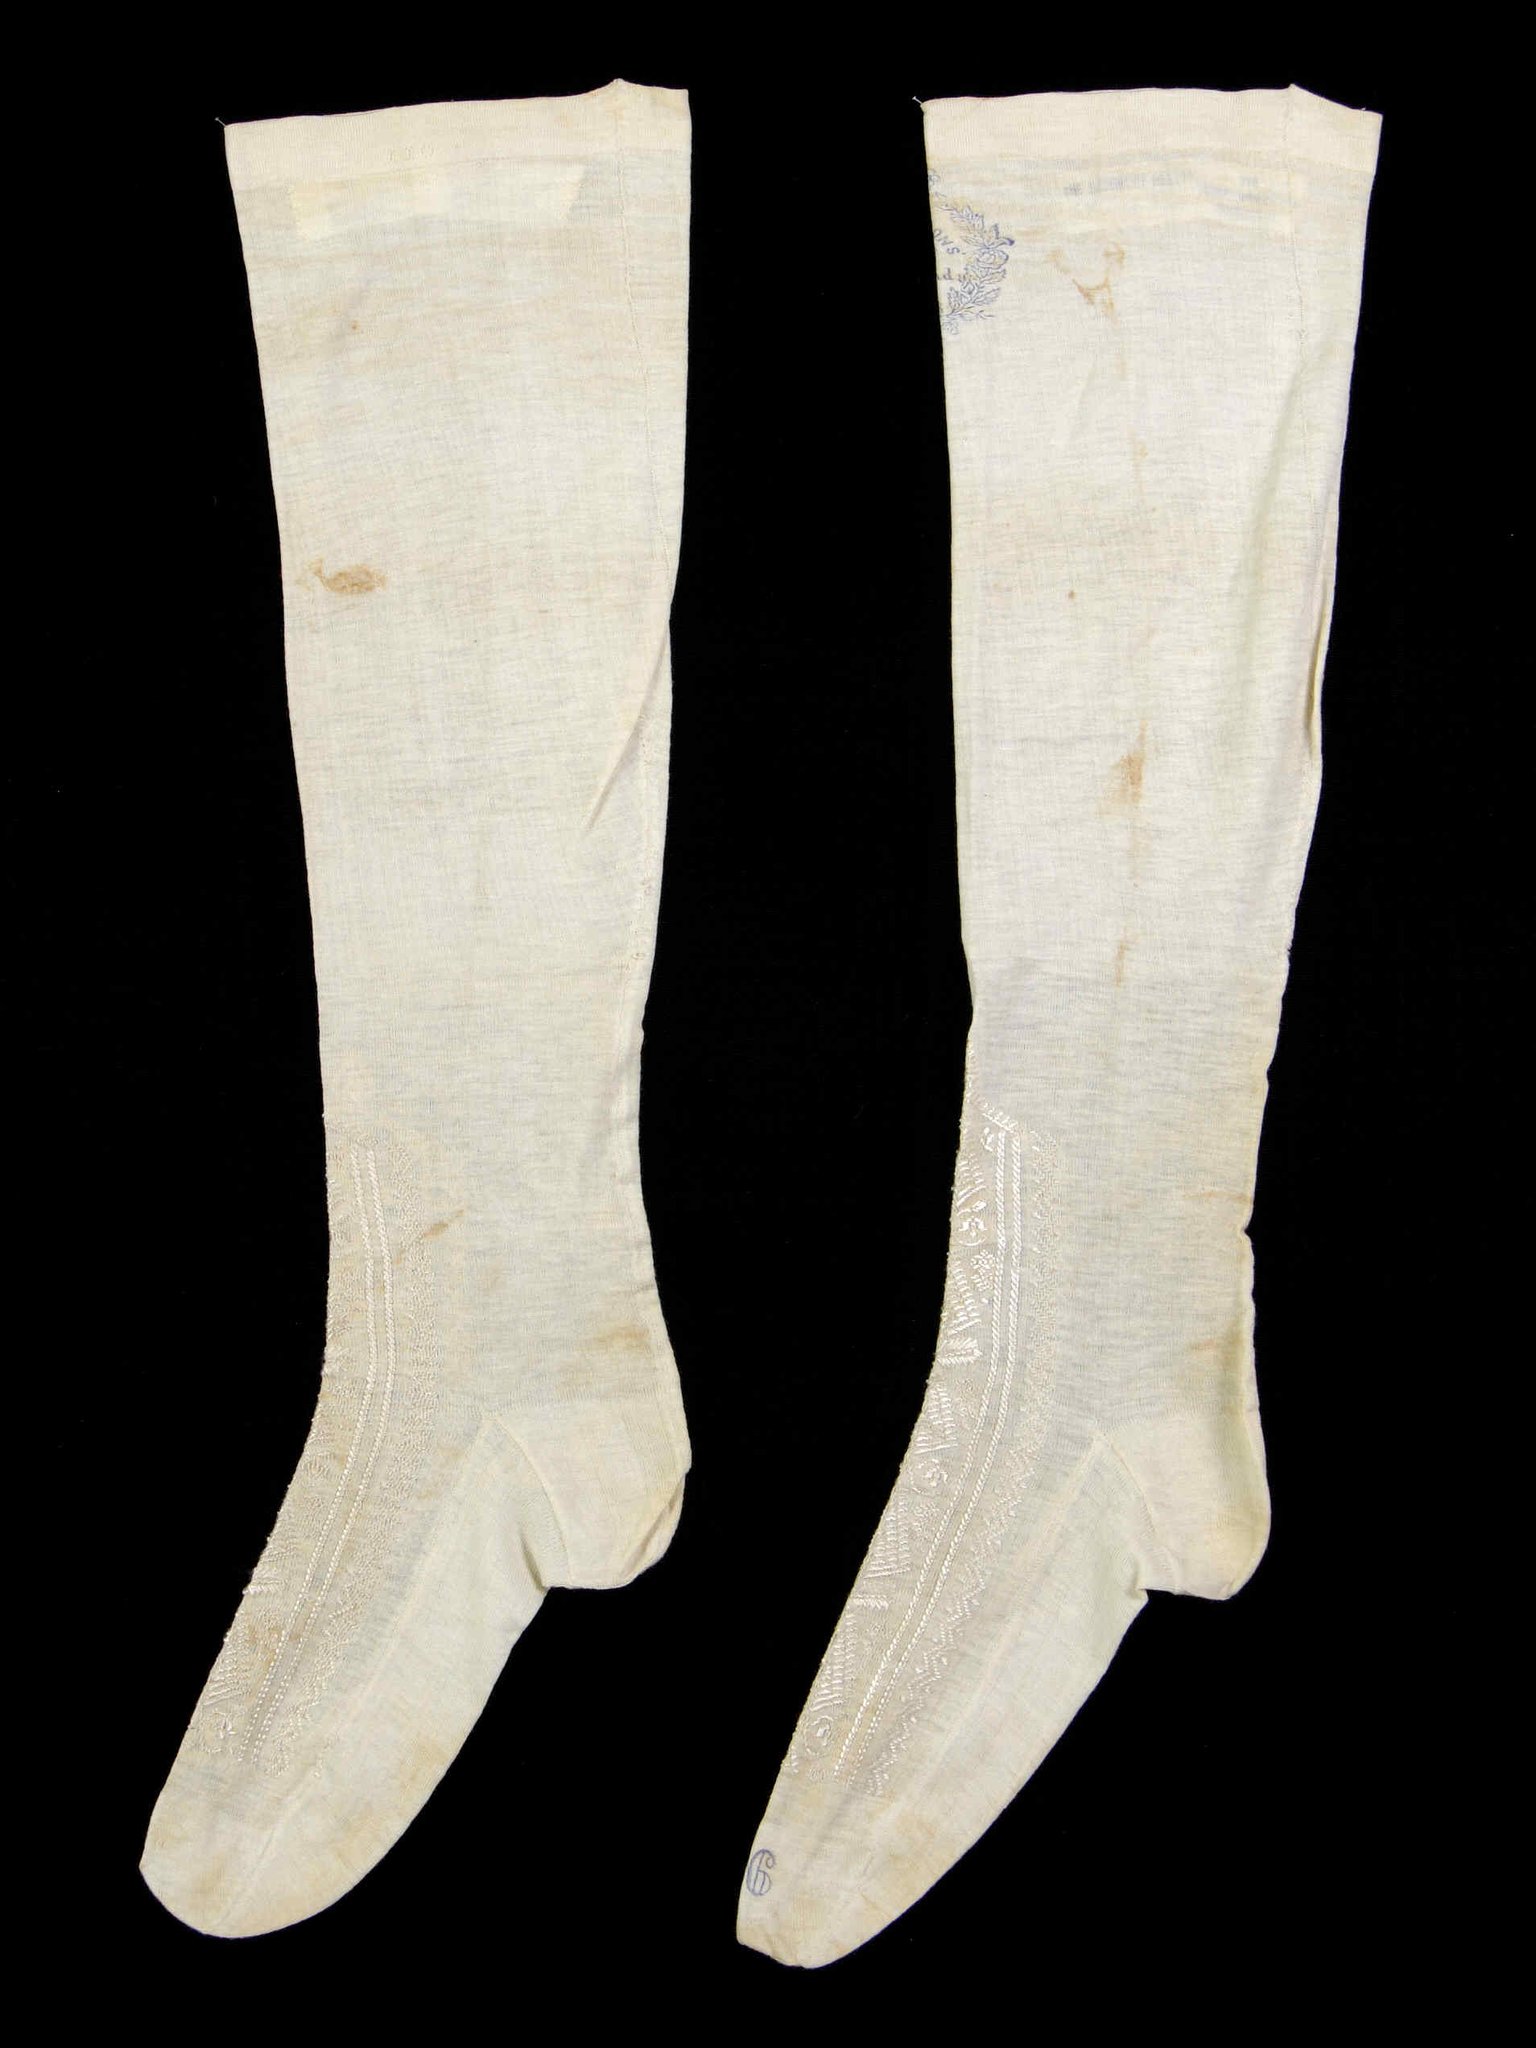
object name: stocking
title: Stockings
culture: british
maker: c. pecker & sons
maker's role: manufacturer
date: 1860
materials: cotton, silk